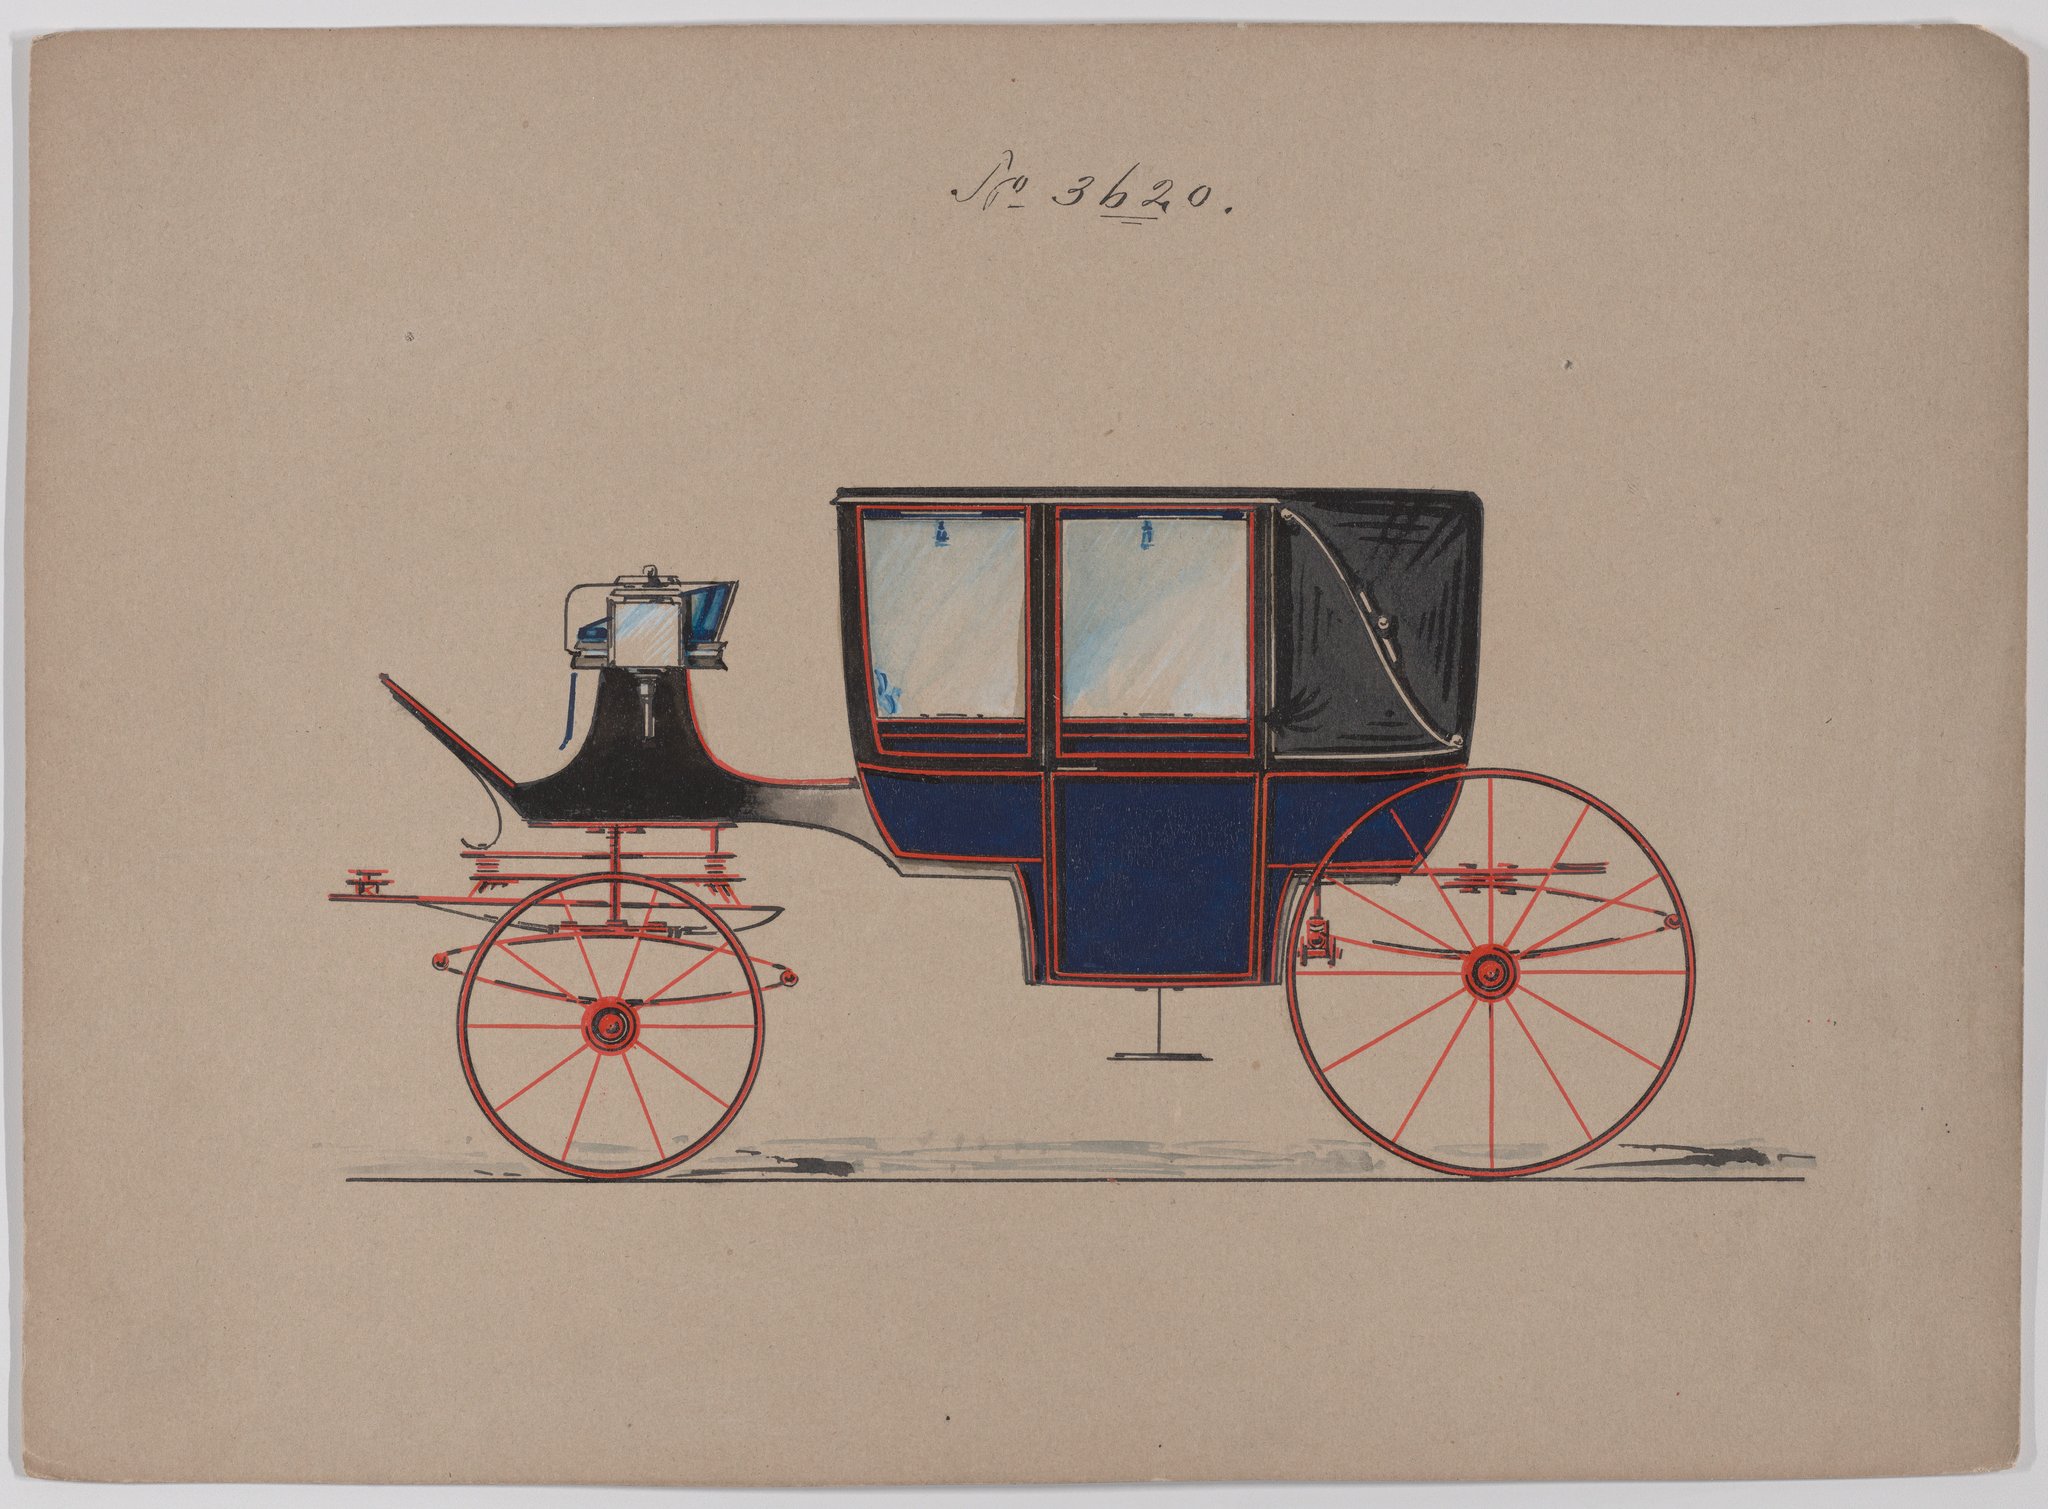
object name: drawing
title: Design for Landau, No. 3620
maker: brewster & co.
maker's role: manufacturer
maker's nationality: american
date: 1880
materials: gouache, gum arabic, ink, watercolor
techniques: pen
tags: carriages